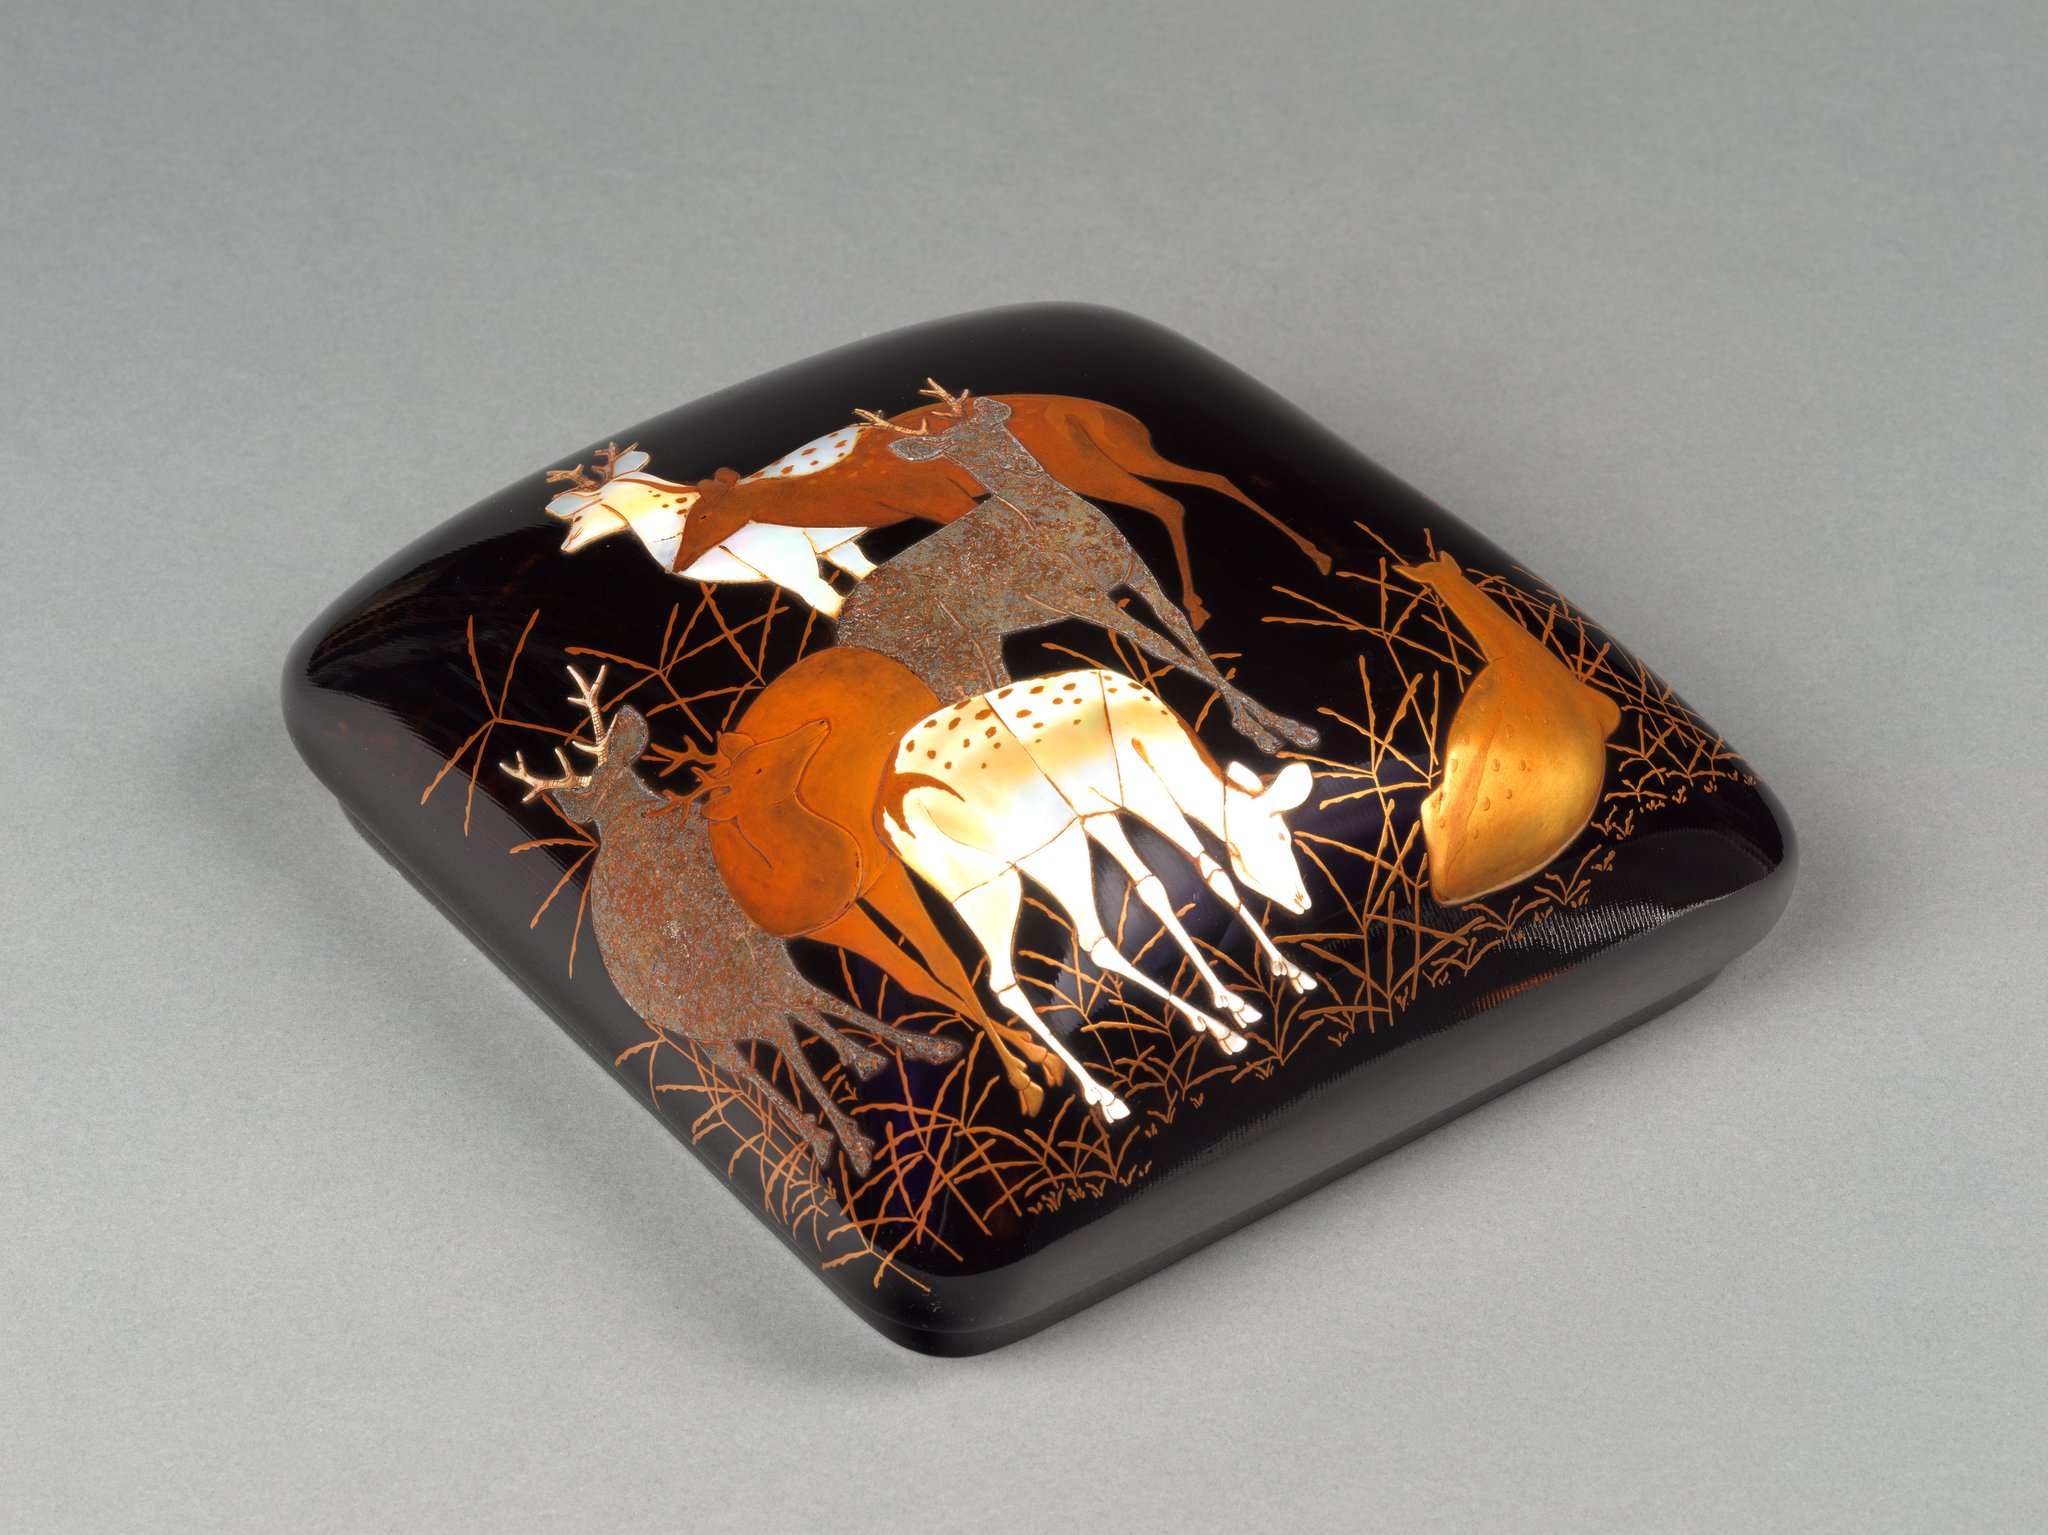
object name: writing box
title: Writing box with decoration of seven deer in autumn grasses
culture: japanese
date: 1801-1900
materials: gold, lacquer, lead, mother of pearl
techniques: inlay, maki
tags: deer